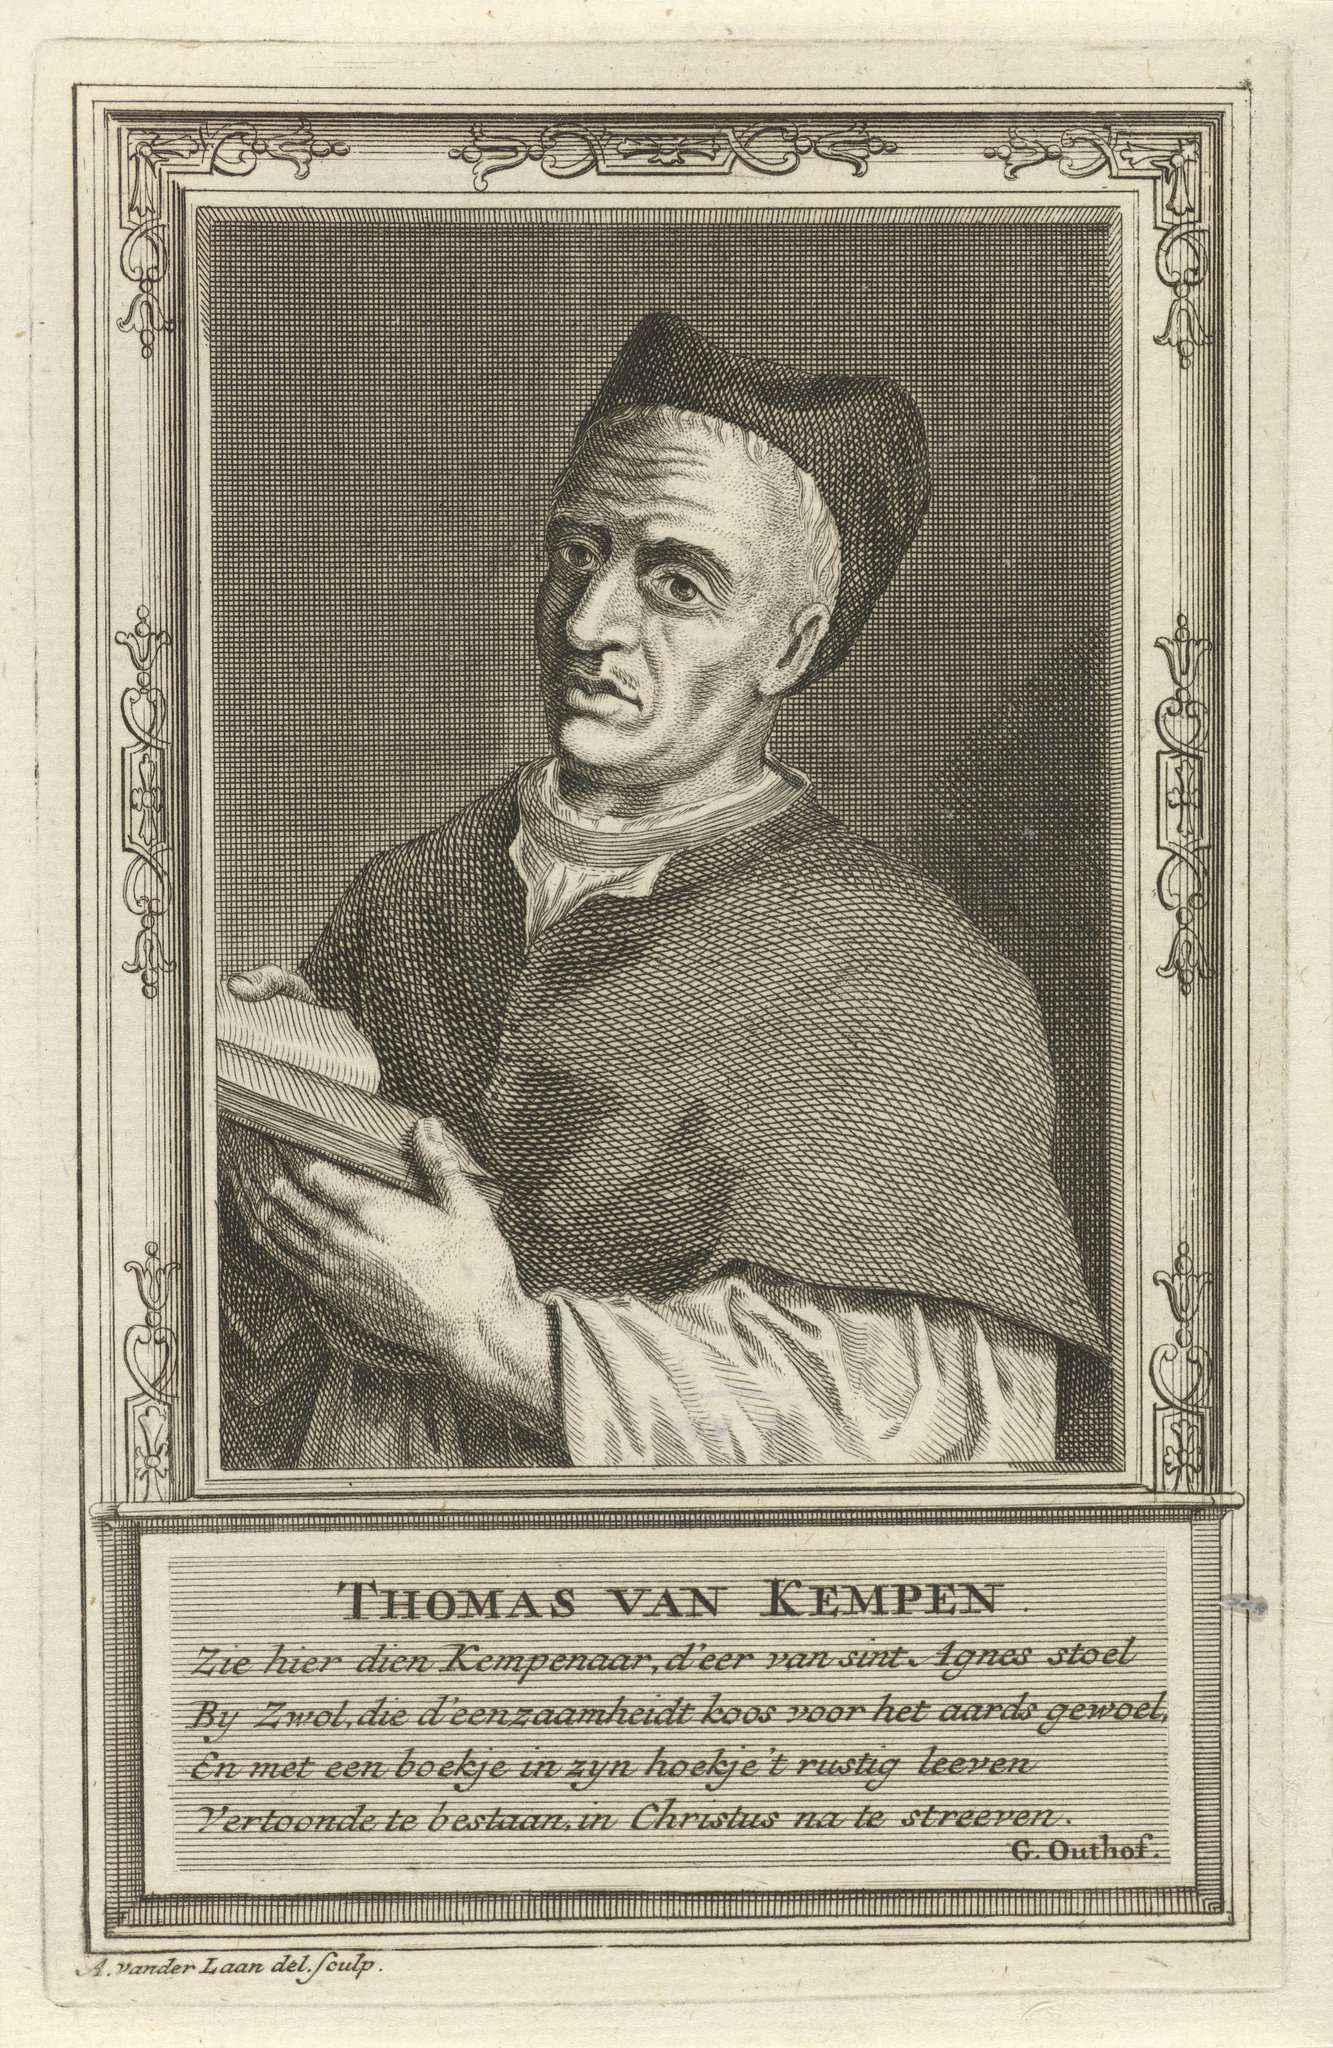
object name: print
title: Portret van Thomas à Kempis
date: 1694-1755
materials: paper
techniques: engraving, etching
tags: priest, thomas à kempis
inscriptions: collector's mark: Lugt 2228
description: Portretbuste naar links van de priester Thomas à Kempis, met hoofddeksel en een opgeslagen boek in zijn handen. Rondom een ornamentele lijst, onder het portret de naam van de geportretteerde en een vierregelig Nederlands vers.